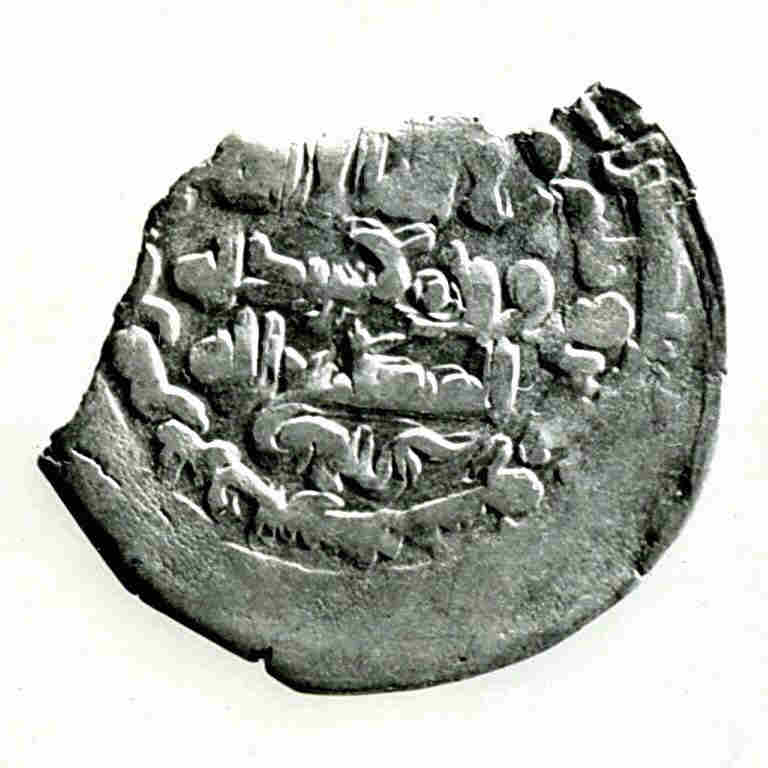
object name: coin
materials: silver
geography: iran